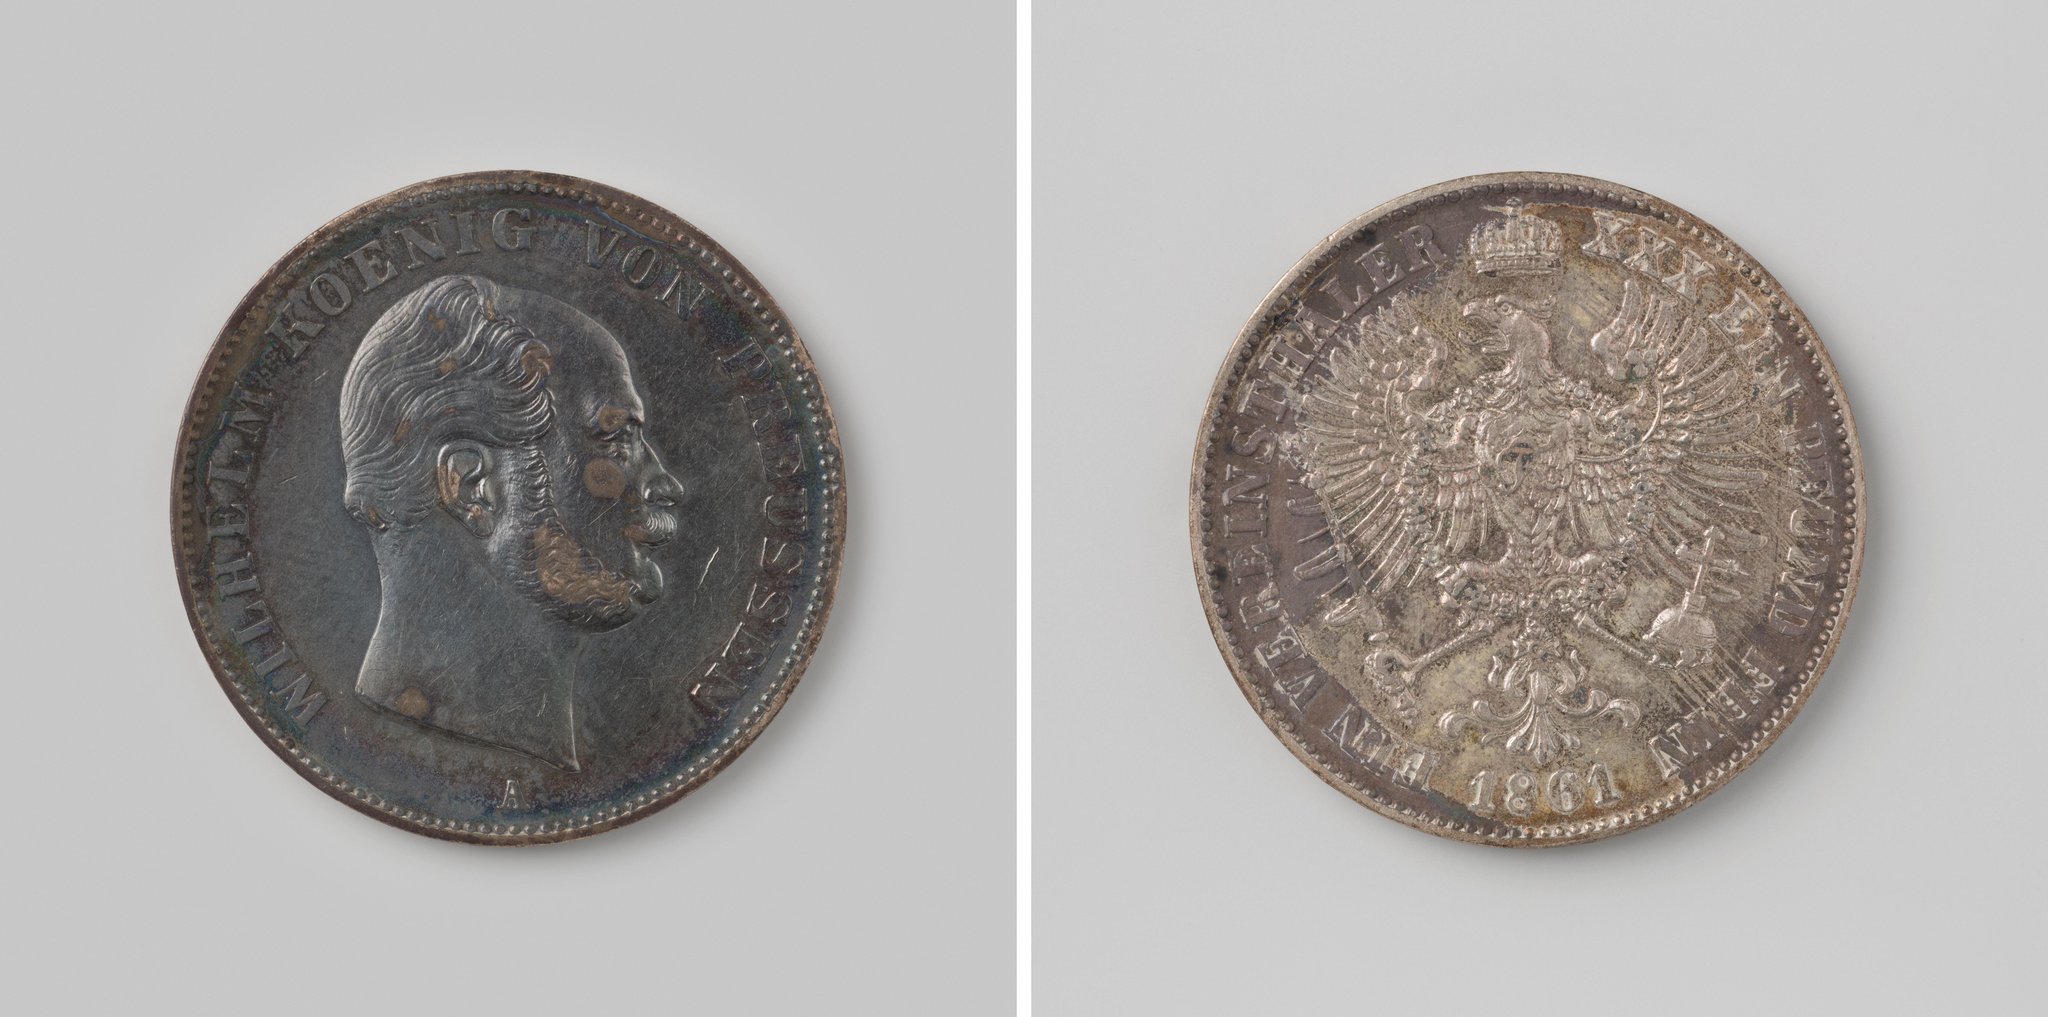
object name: vereinstaler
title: Pruisen, Wilhelm I, vereinsthaler, 1861 A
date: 1861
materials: silver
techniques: striking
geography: berlin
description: Zilveren munt. Voorzijde: hoofd van de koning naar rechts. Daaronder letter A. Keerzijde: door keten en juweel van een ridderorde omhangen gekroonde enkelkoppige adelaar met in zijn poten scepter en rijksappel. Waarde-aanduiding in omschrift met jaartal onderaan. Randschrift.